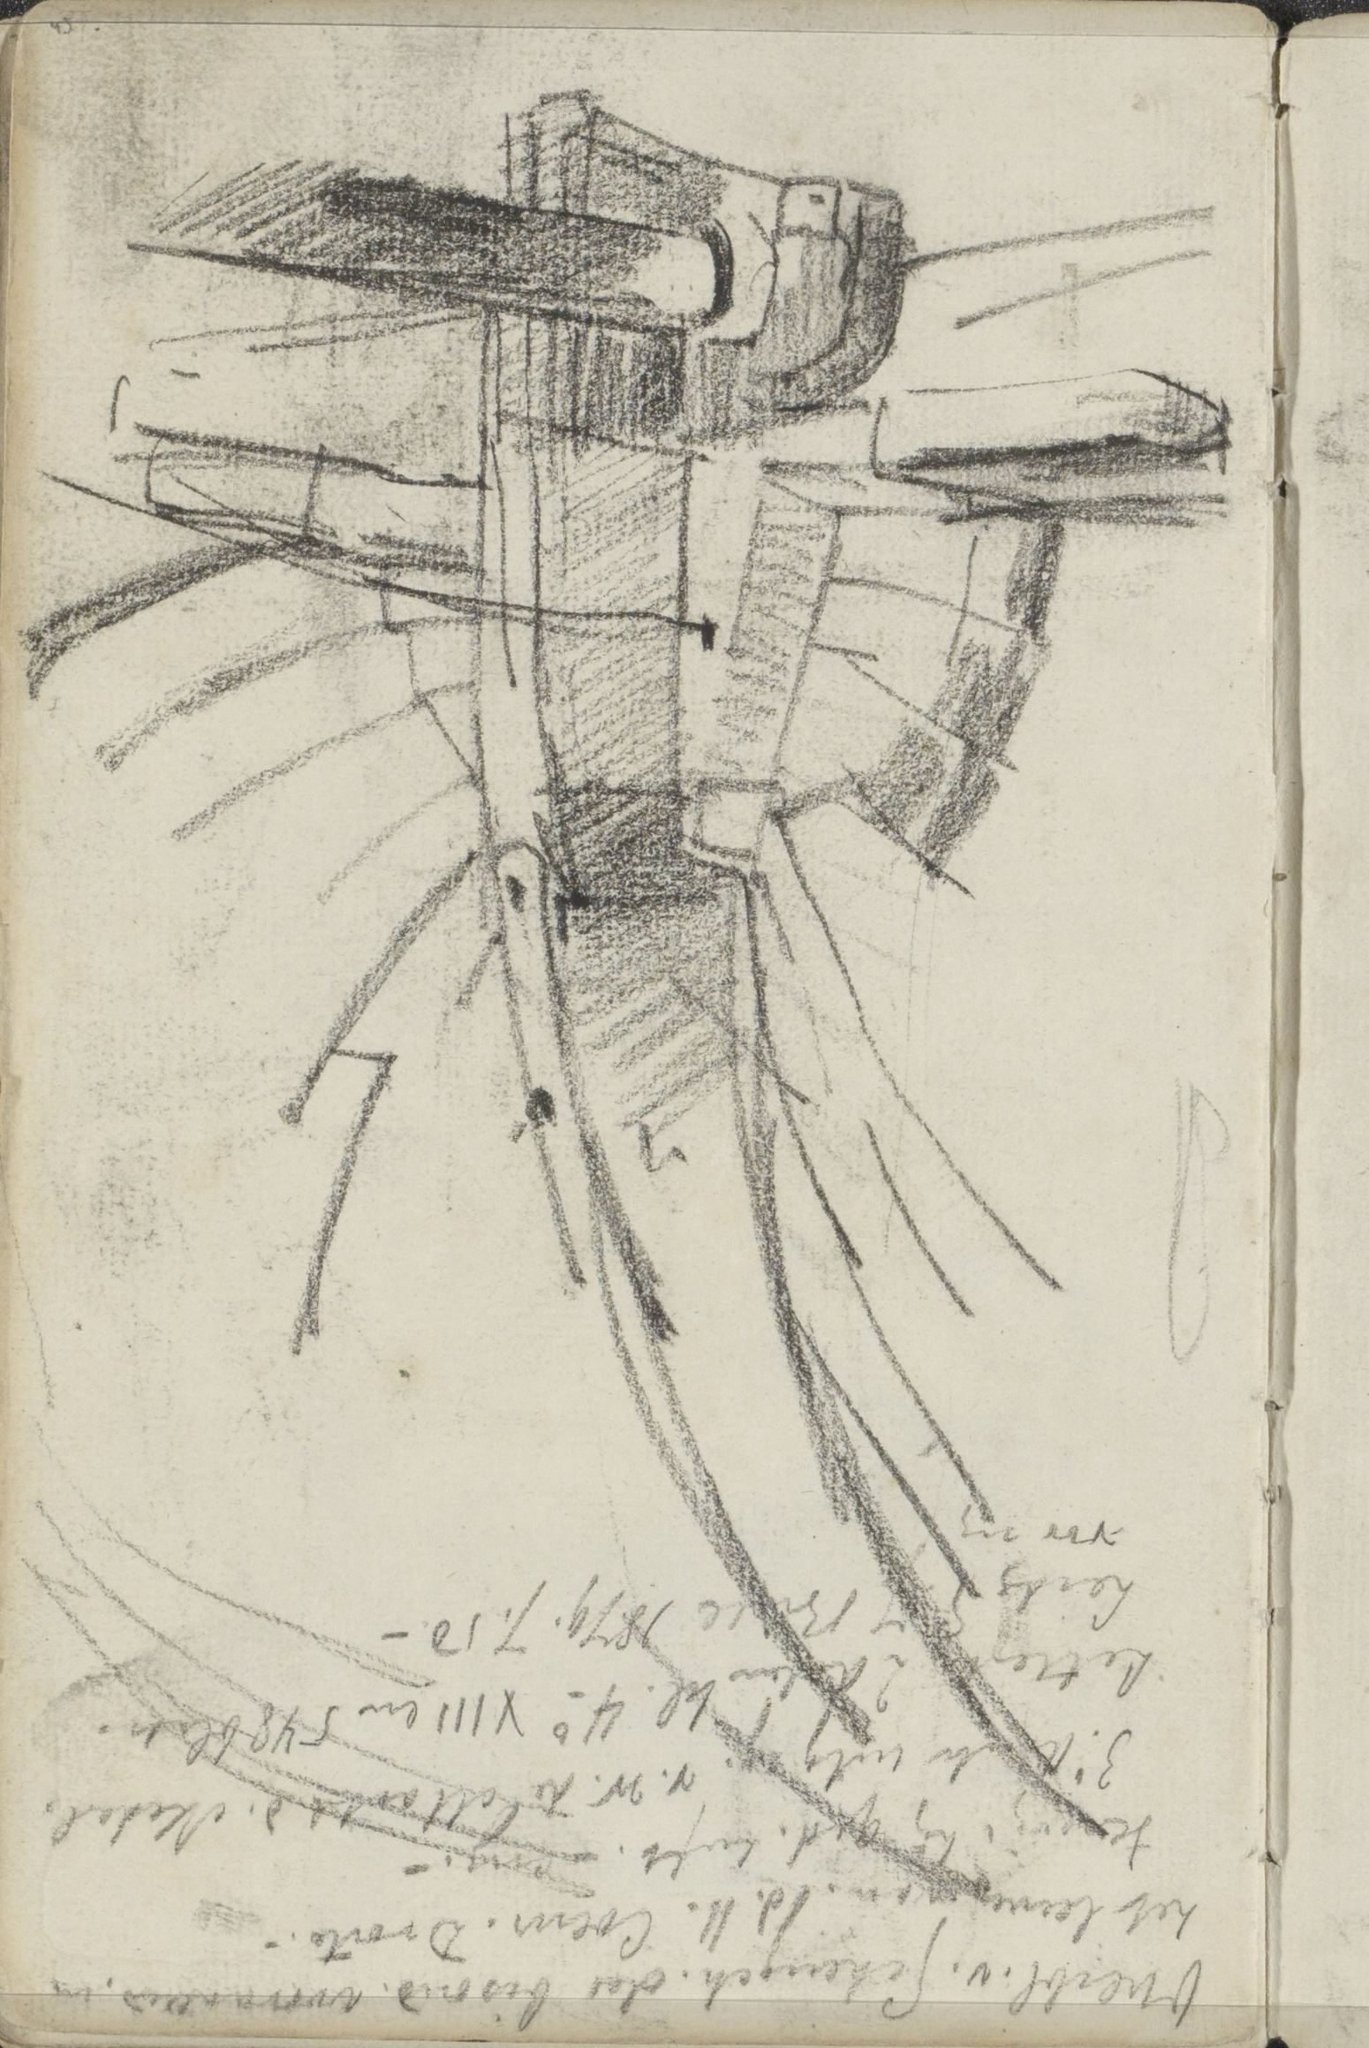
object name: sketchbook leaf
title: Studie, mogelijk van een bootonderdeel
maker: george hendrik breitner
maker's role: draughtsman, painter, print maker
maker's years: 1857-1923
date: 1880-1882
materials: chalk, paper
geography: the hague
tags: ships (in general)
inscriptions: annotation: ‘Overbl. v. Geheugch. der bisond. voorvallen, in/ het leven van d. H. Coenr. Droste/ terwijl hij ged. heeft. [...]/ 3e druk uitg. v.w. de Maatsch. d. Nederl./ Letterk. 2 delen kl. 4o XIII en 548 bladz./ Leiden E.J. Brill 1879. 7,50/ [...]’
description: Pagina 45 uit een schetsboek met 23 bladen.